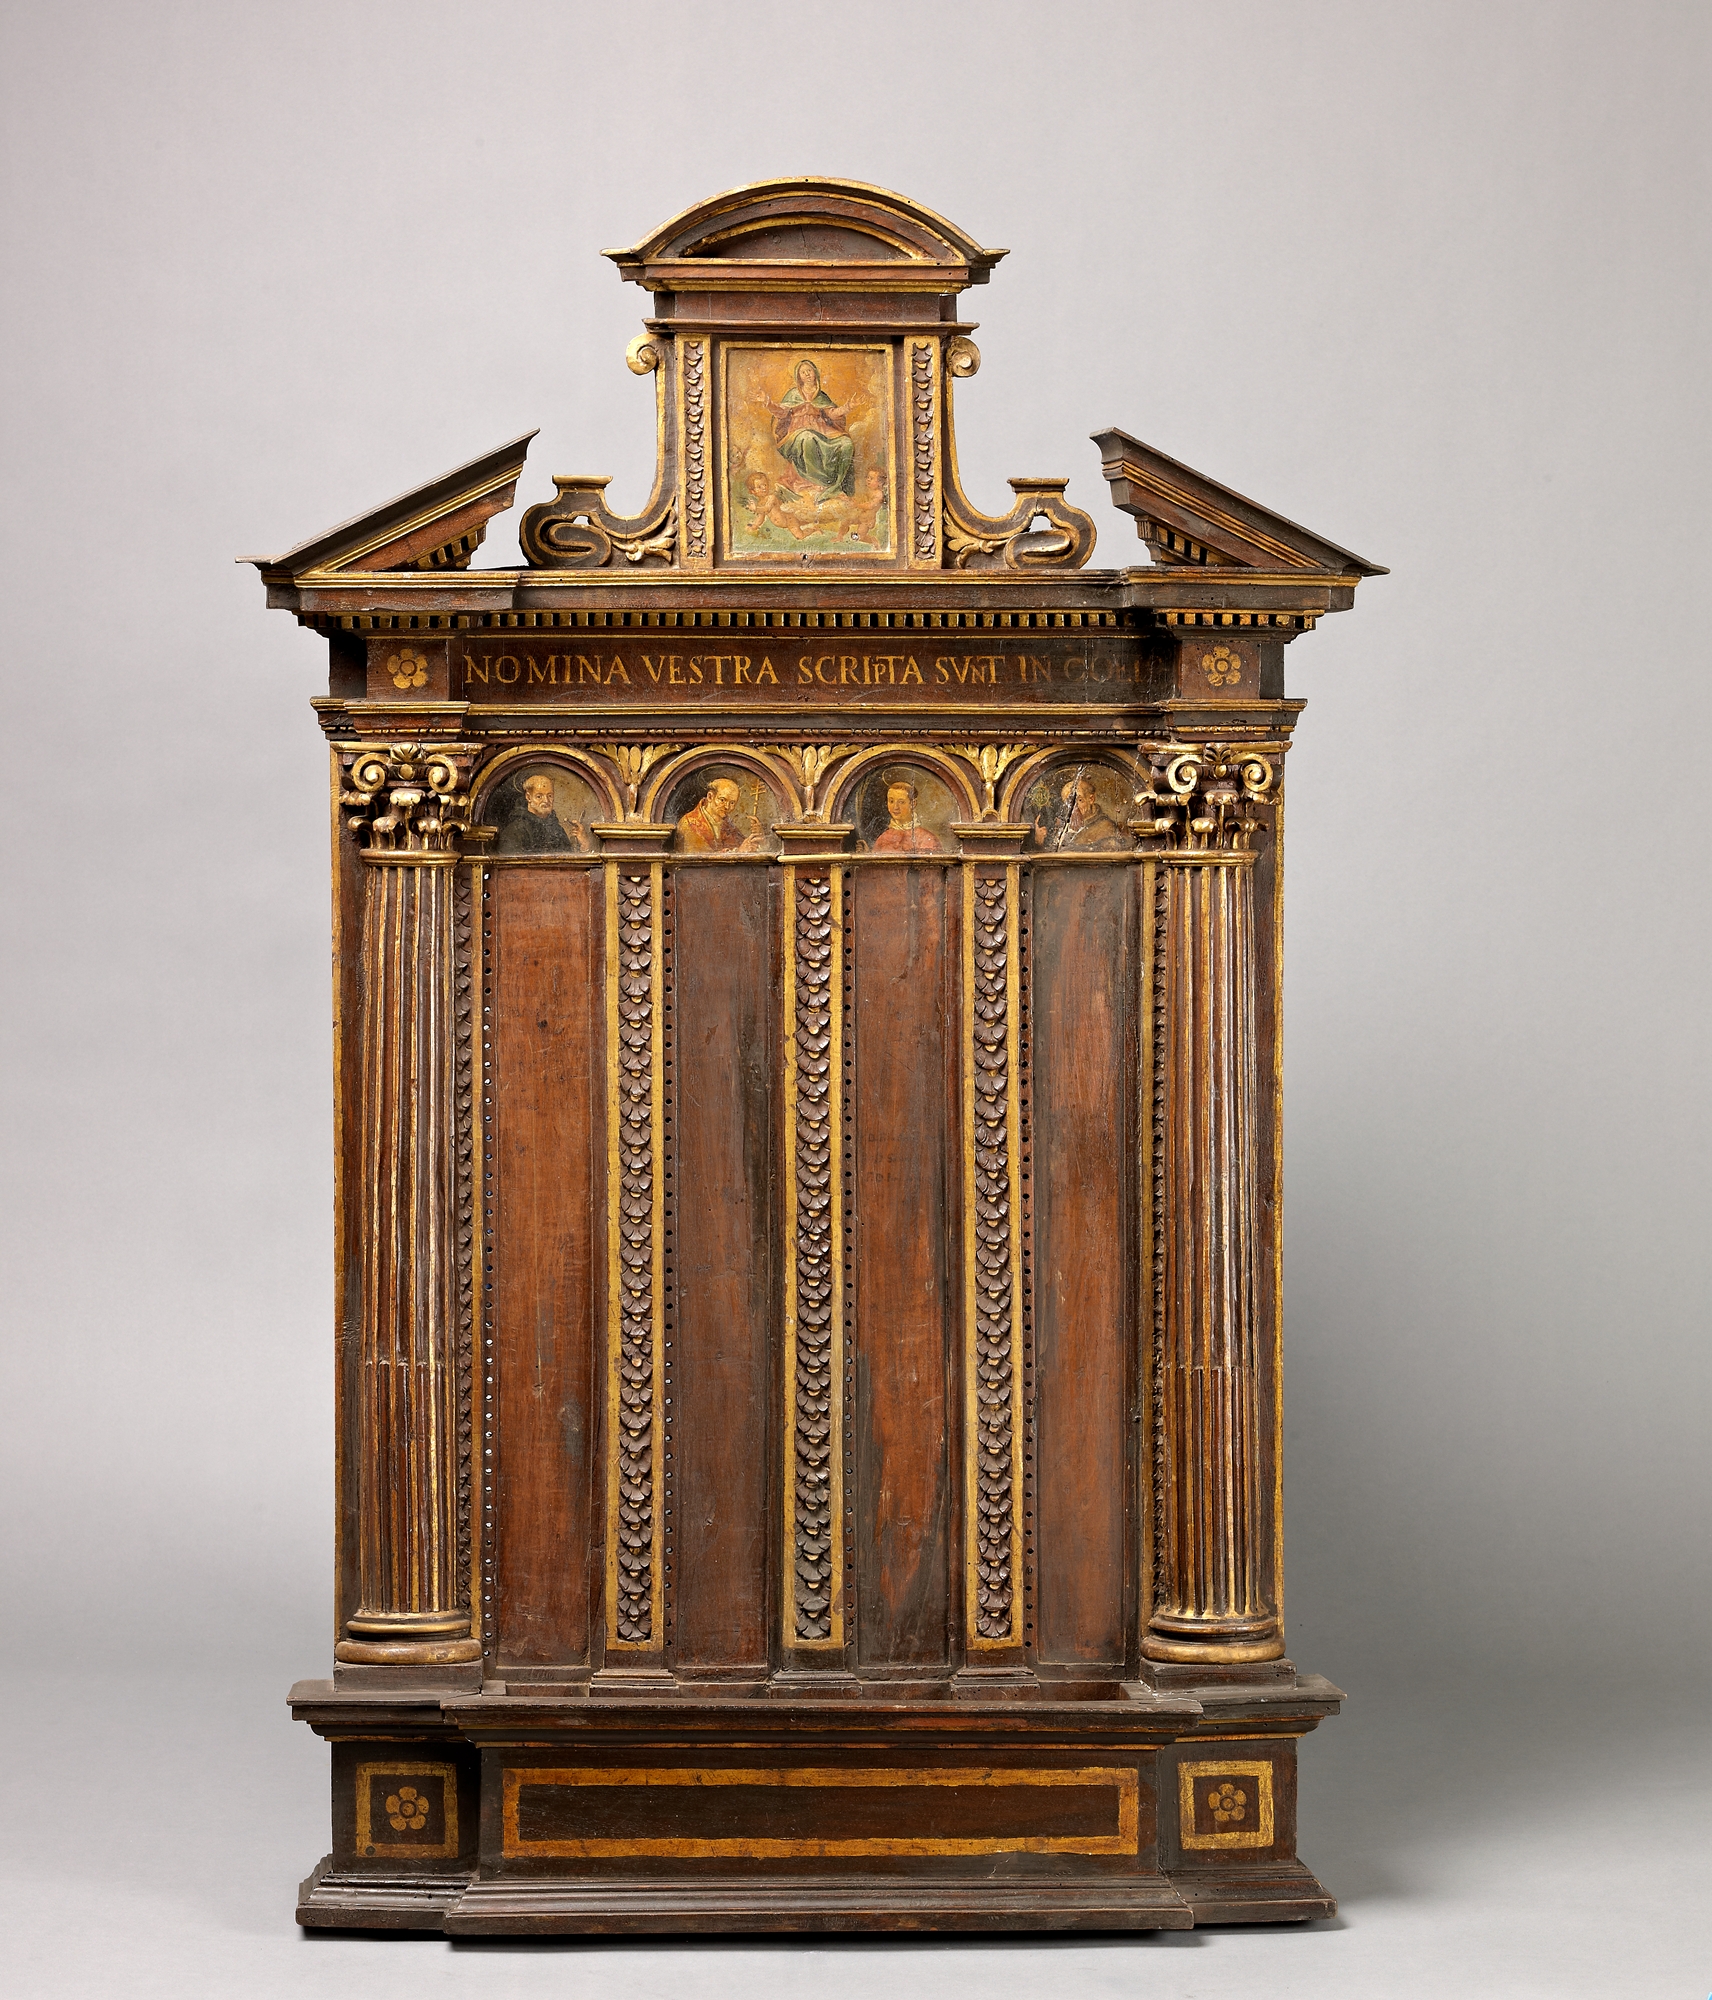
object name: confraternity board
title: Confraternity Board (Tabella di Confraternita)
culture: italian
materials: wood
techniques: carving, gilding, painting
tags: virgin mary